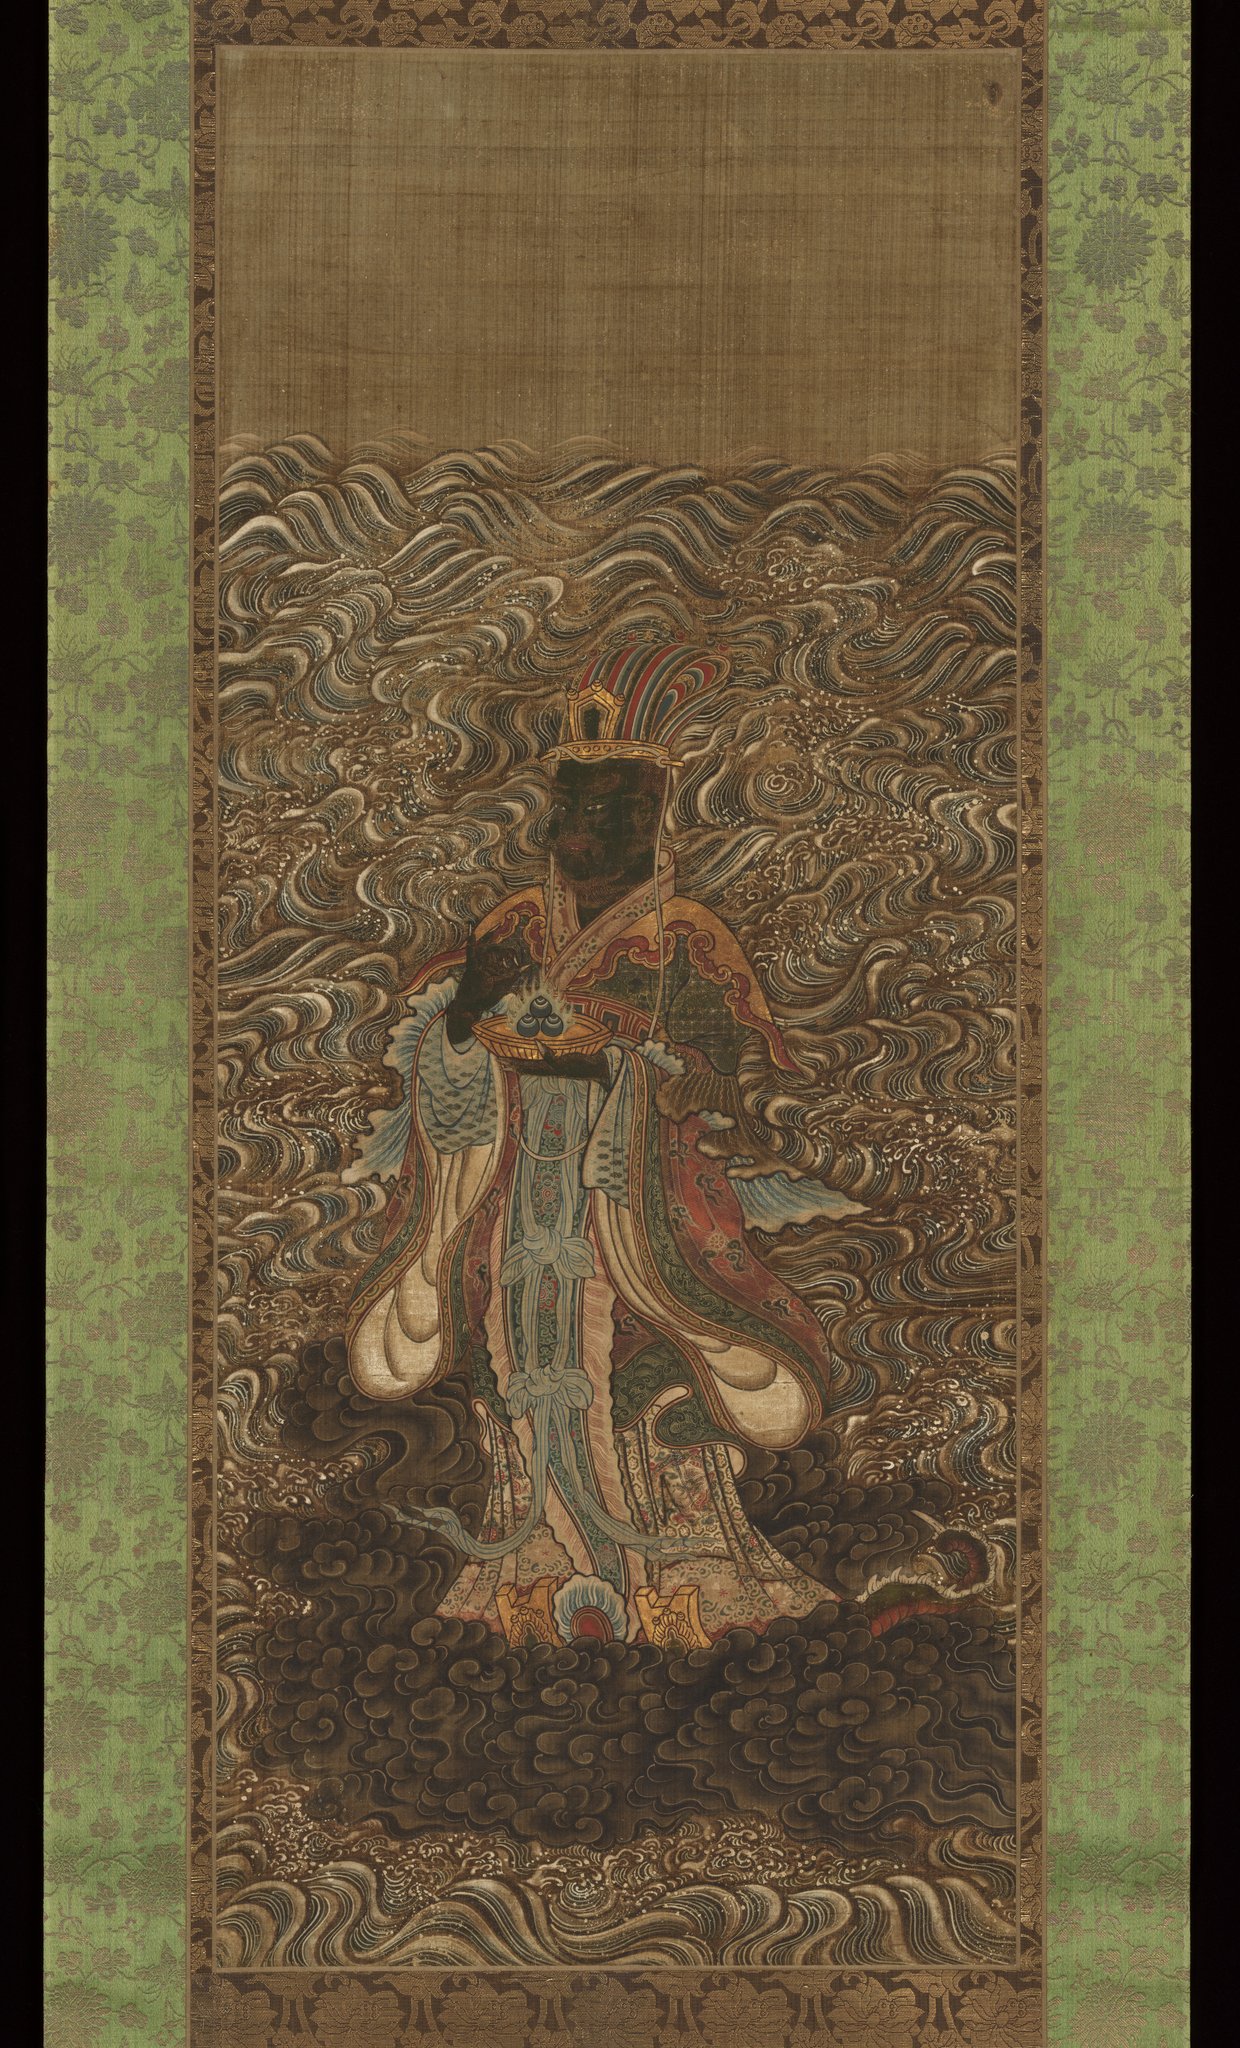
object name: hanging scroll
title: Dragon King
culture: japanese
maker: unidentified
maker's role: artist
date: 1501-1700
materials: gold, ink, silk